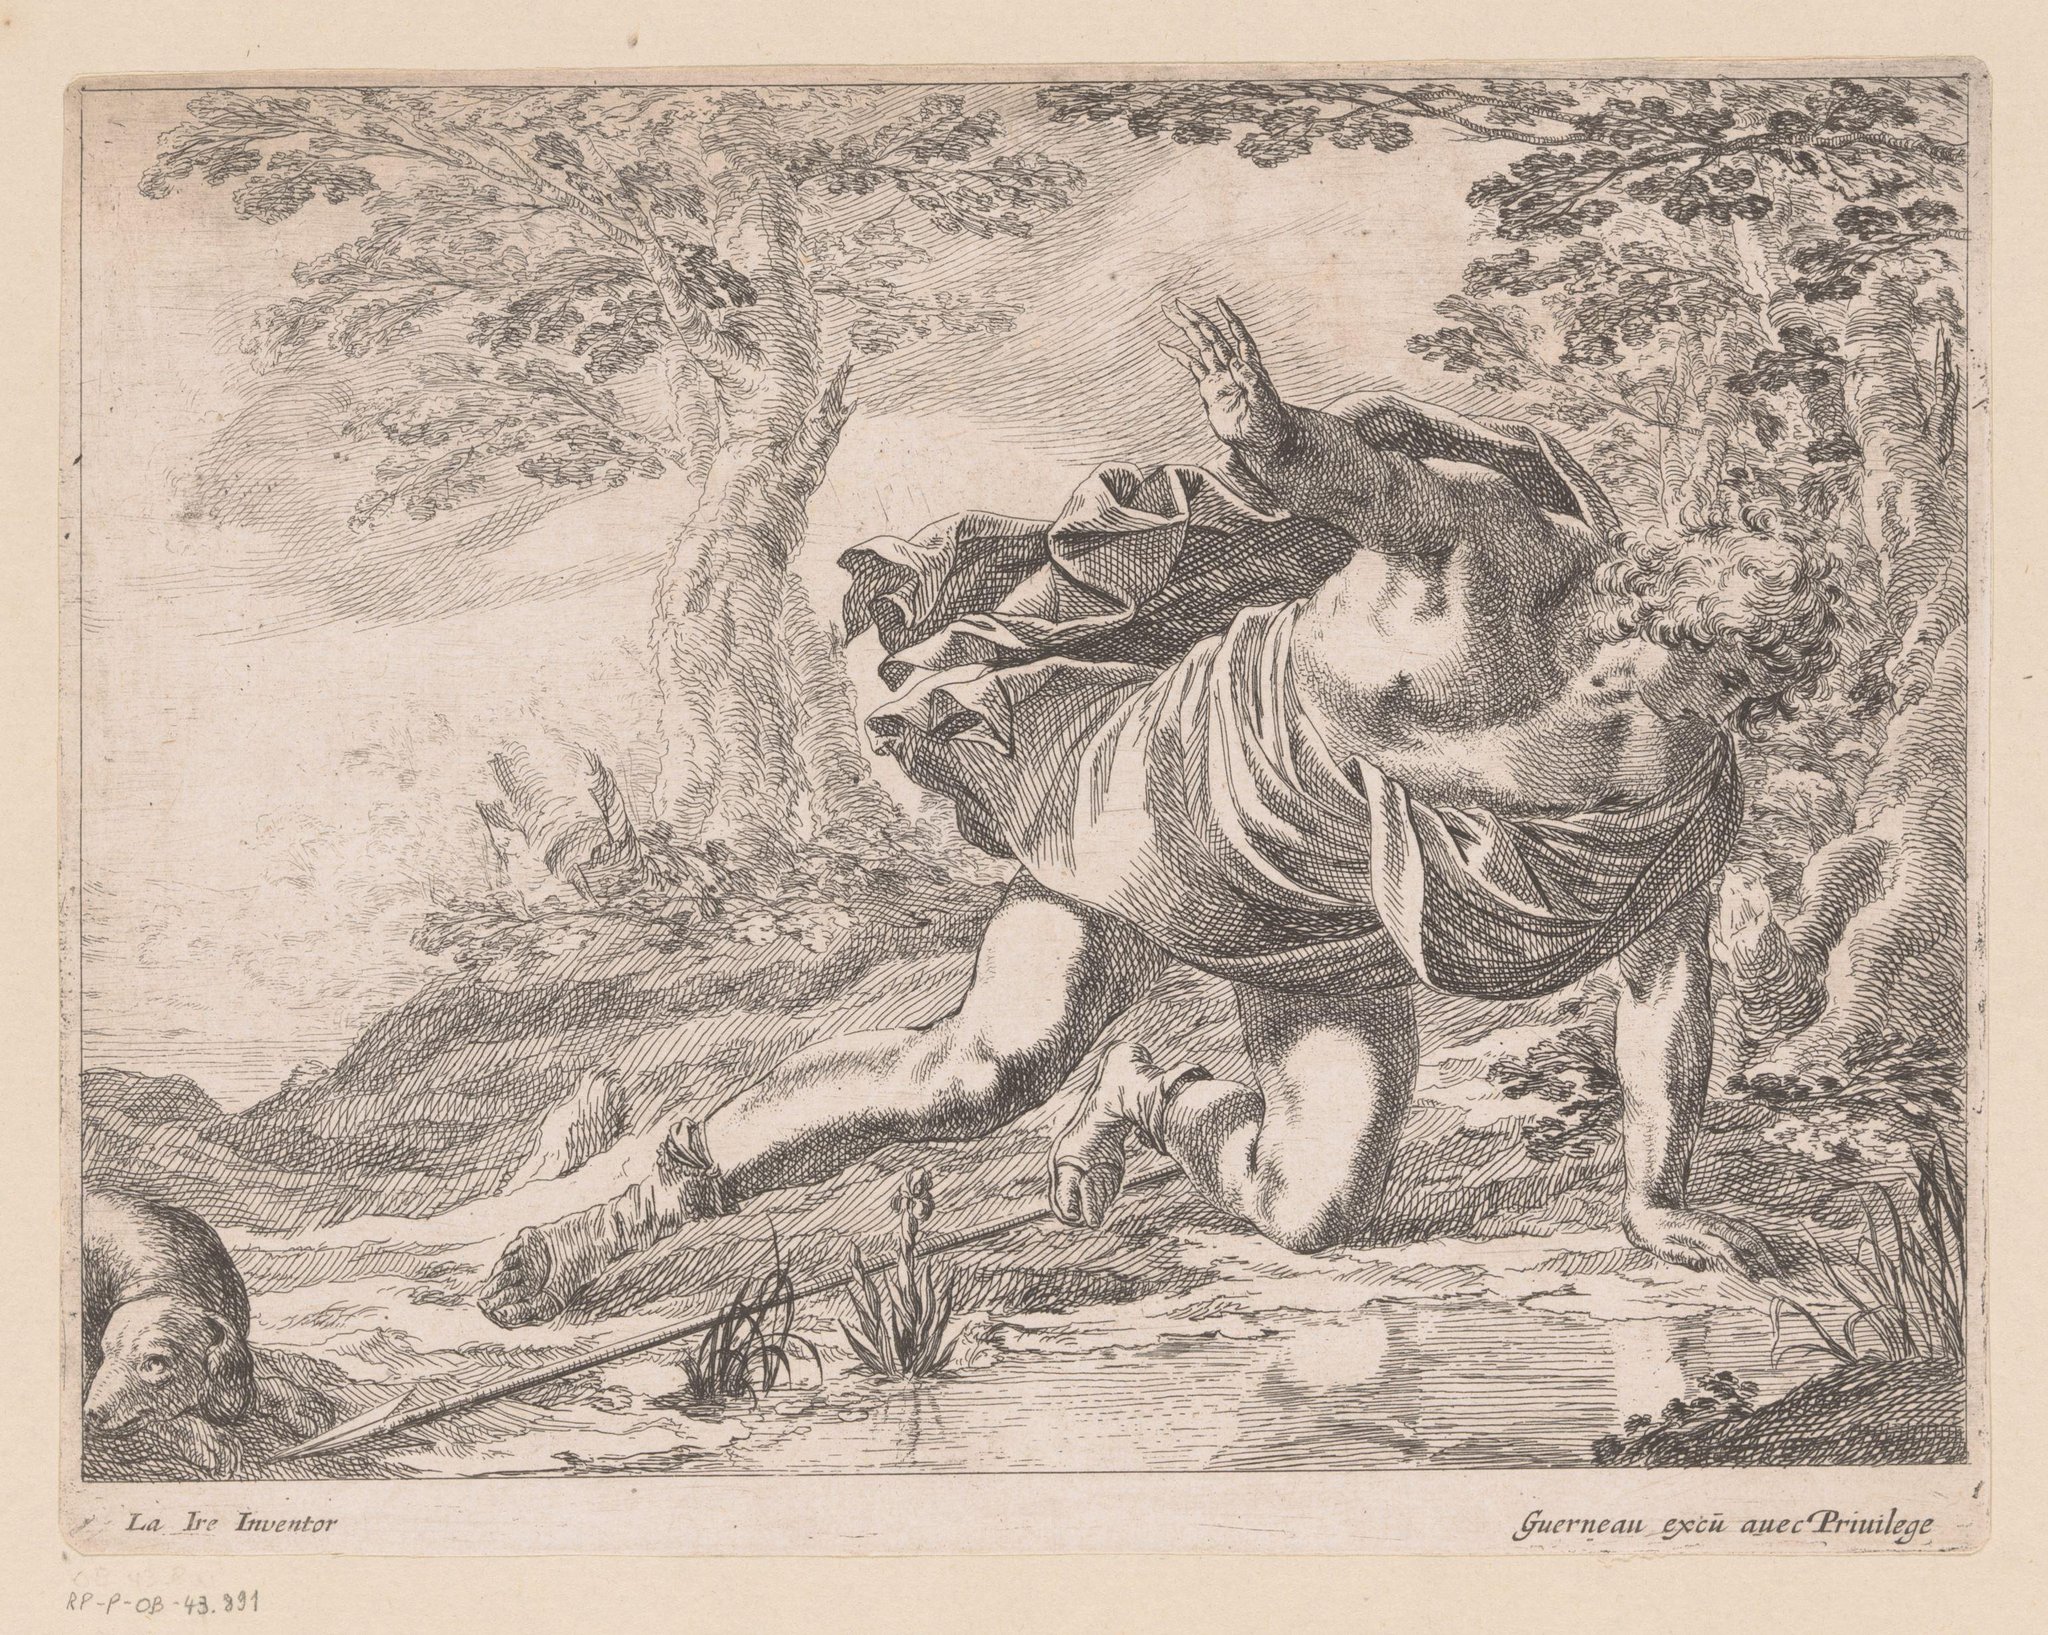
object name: print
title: Narcissus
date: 1616-1656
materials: paper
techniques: etching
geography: paris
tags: (story of) narcissus, dog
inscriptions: collector's mark: Lugt 240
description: Both prints were made by Laurent de la Hire, a French artist who concentrated on mythological and religious subjects. Although the landscapes here are similar, the atmosphere is different. On the left, Narcissus looks at his reflection in a relaxed, almost nonchalant manner. In the print on the right, which is from a later date, there is no longer any question of tranquillity: Narcissus is startled by the confrontation with himself. His dog sleeps on unperturbed in both prints.